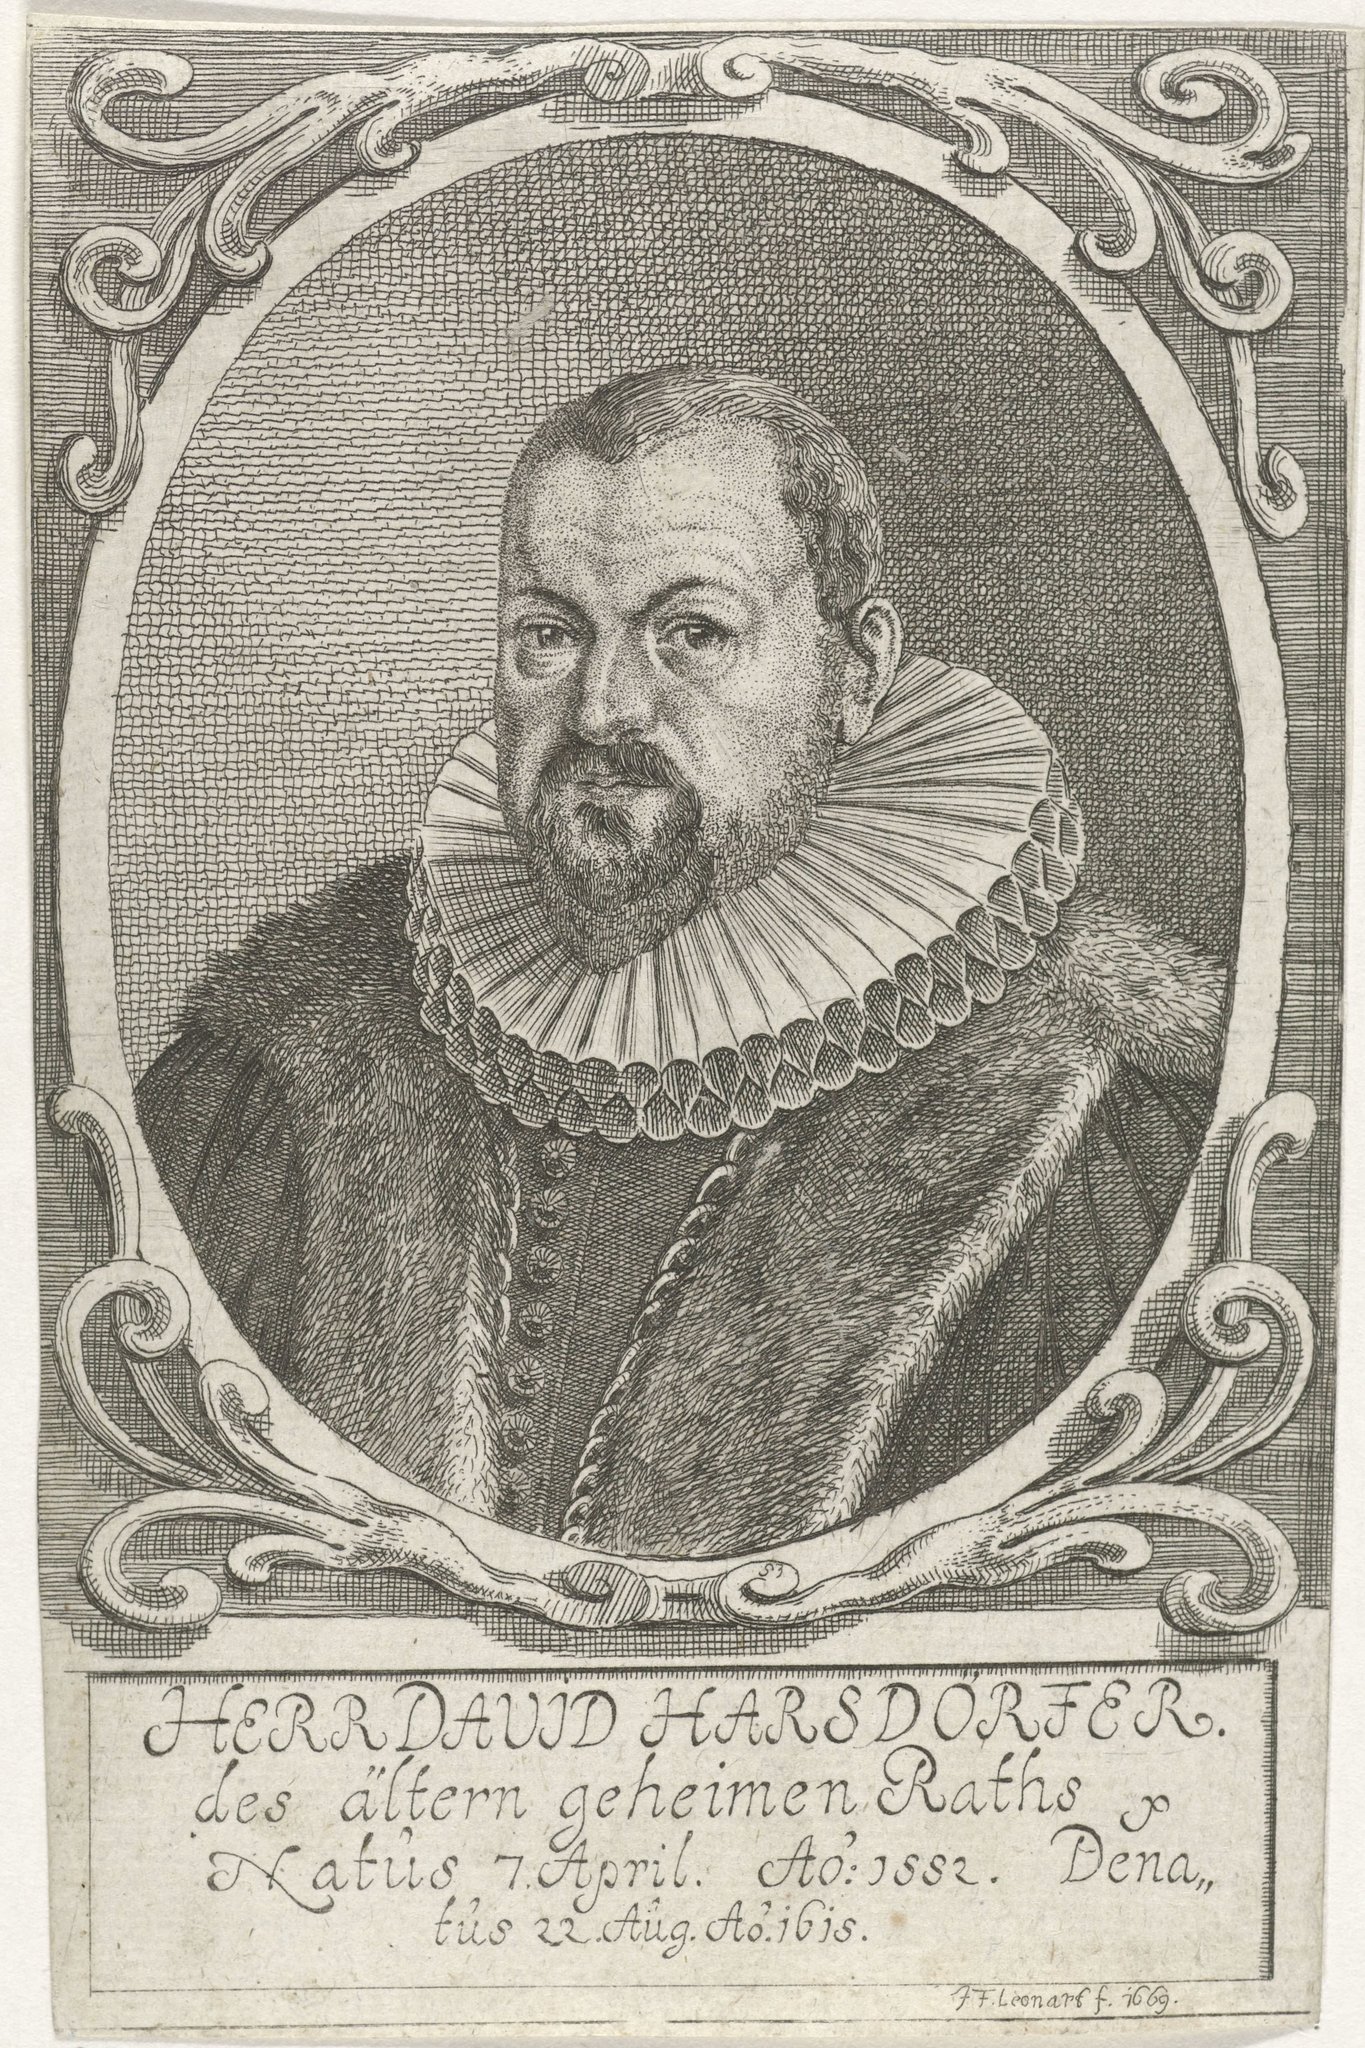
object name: print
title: Portret van David Harsdörffer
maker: johann friedrich leonard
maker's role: print maker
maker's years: 1633-1680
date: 1669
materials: paper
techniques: engraving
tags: raadslid, david harsdörffer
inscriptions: collector's mark: Lugt 2228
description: Portret van David Harsdörffer, lid van de Geheime Raad.